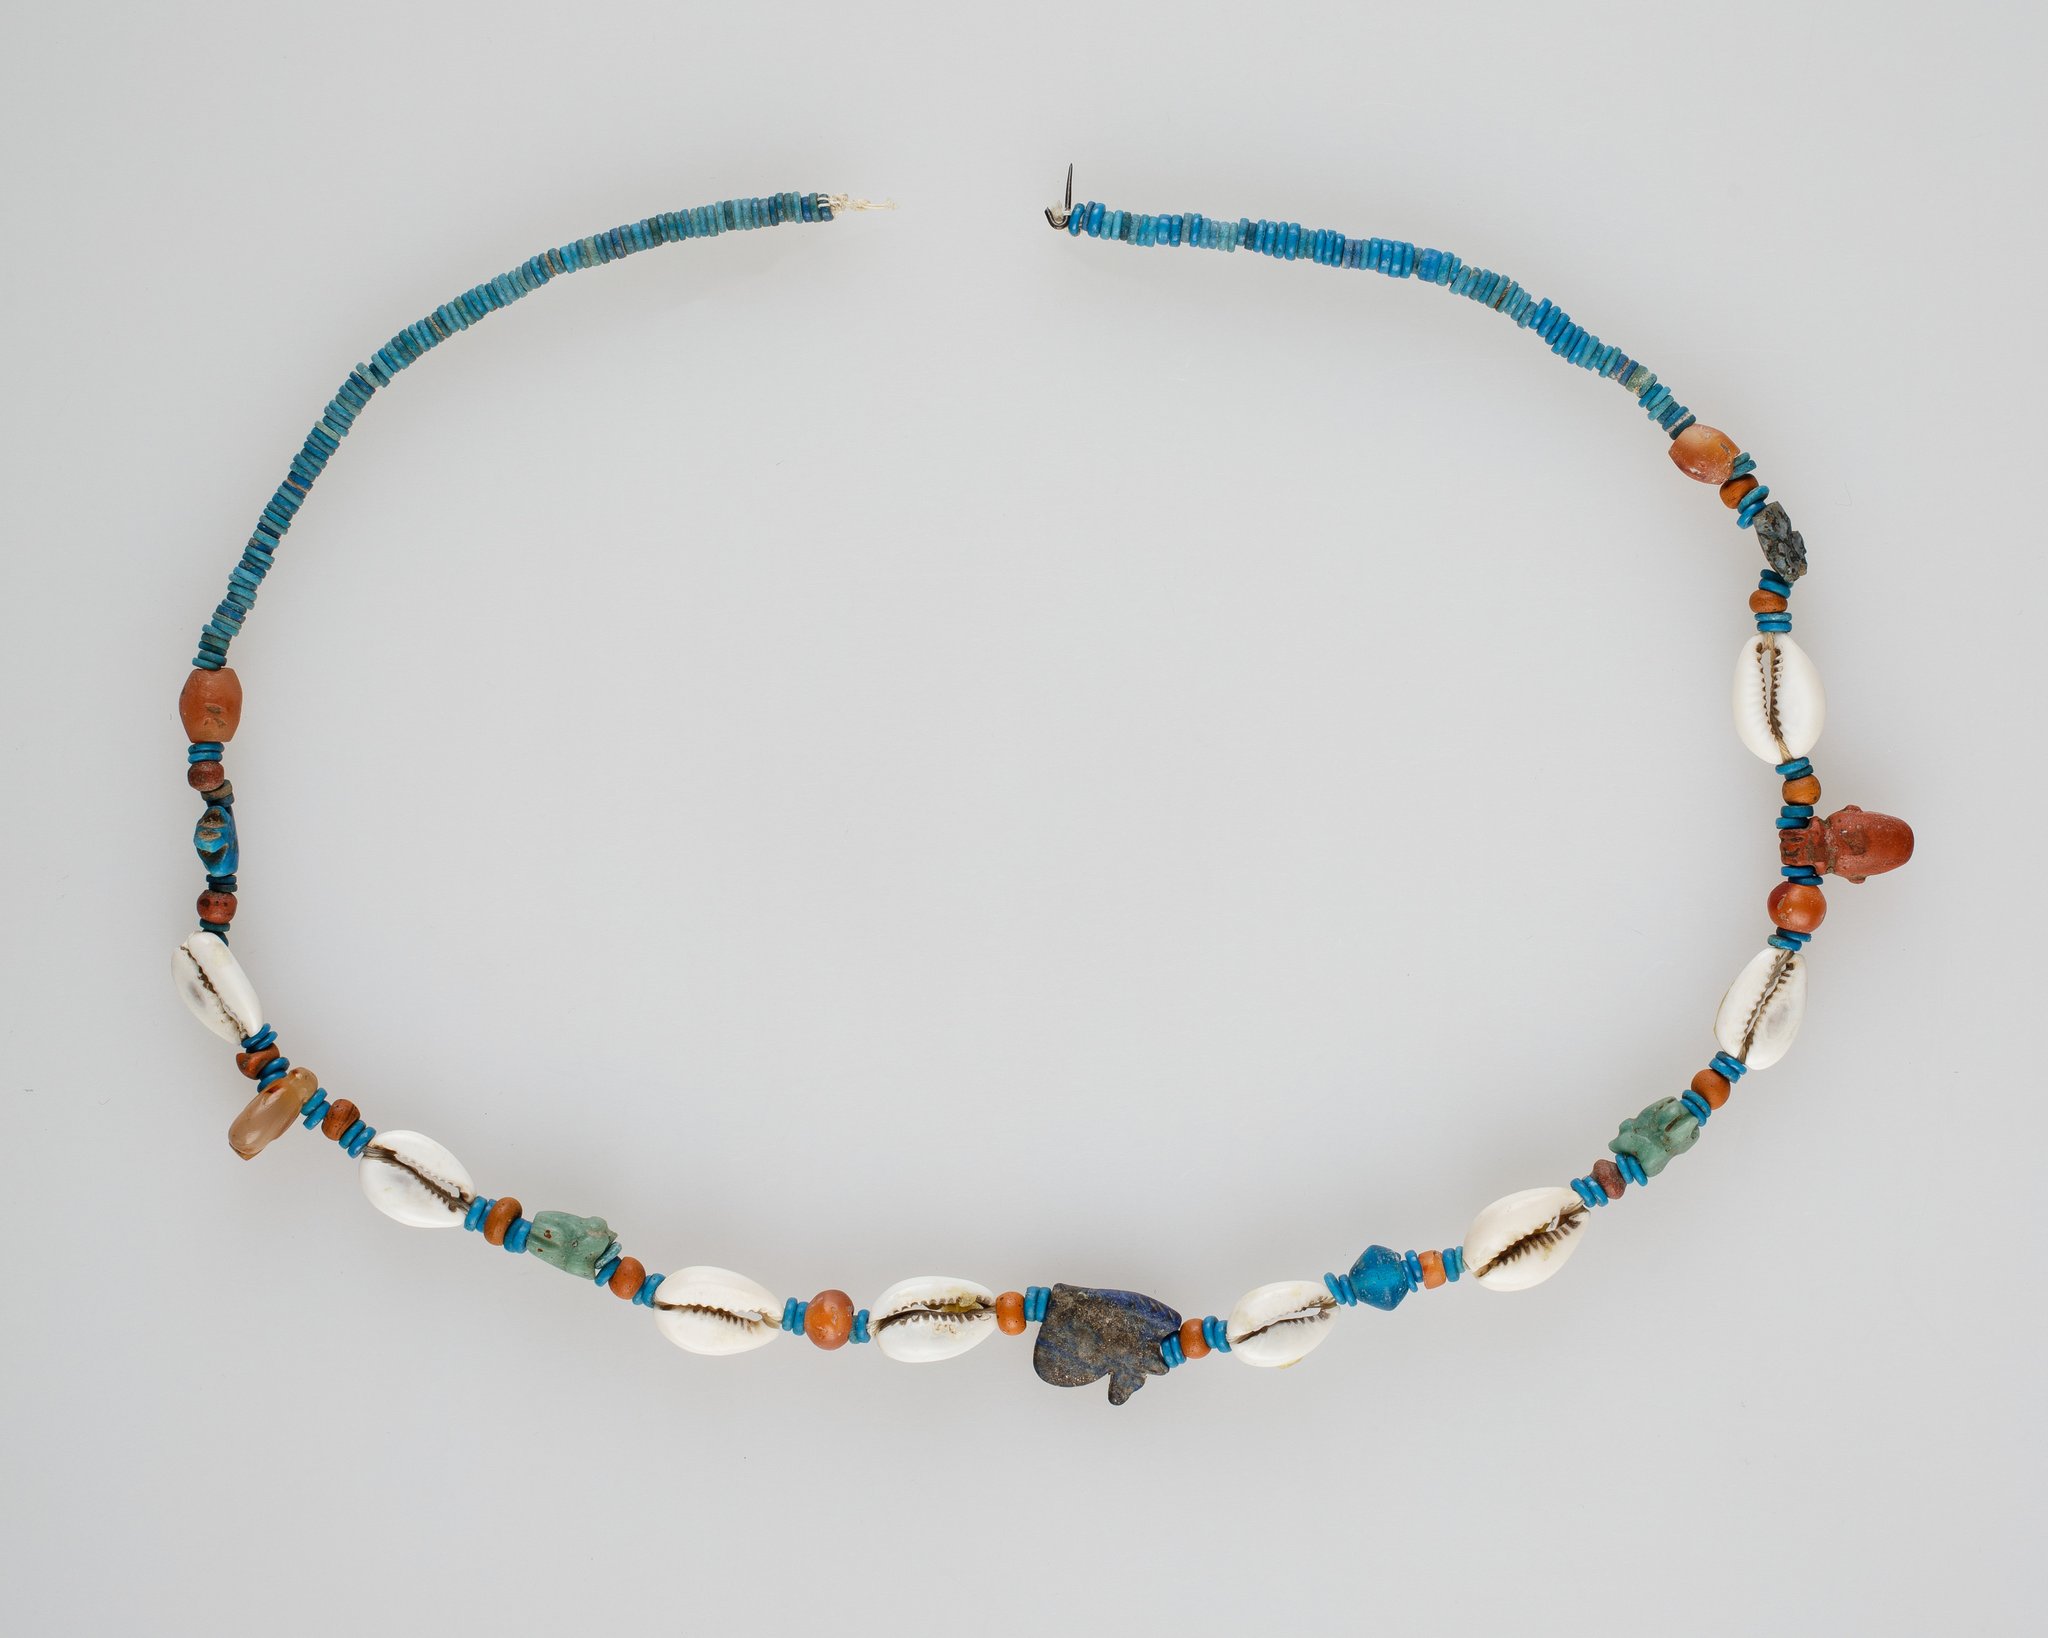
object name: amulet, wedjat eye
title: String of beads and amulets (wedjat eyes)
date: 1070-343 BCE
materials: gemstone, faience, shell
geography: egypt